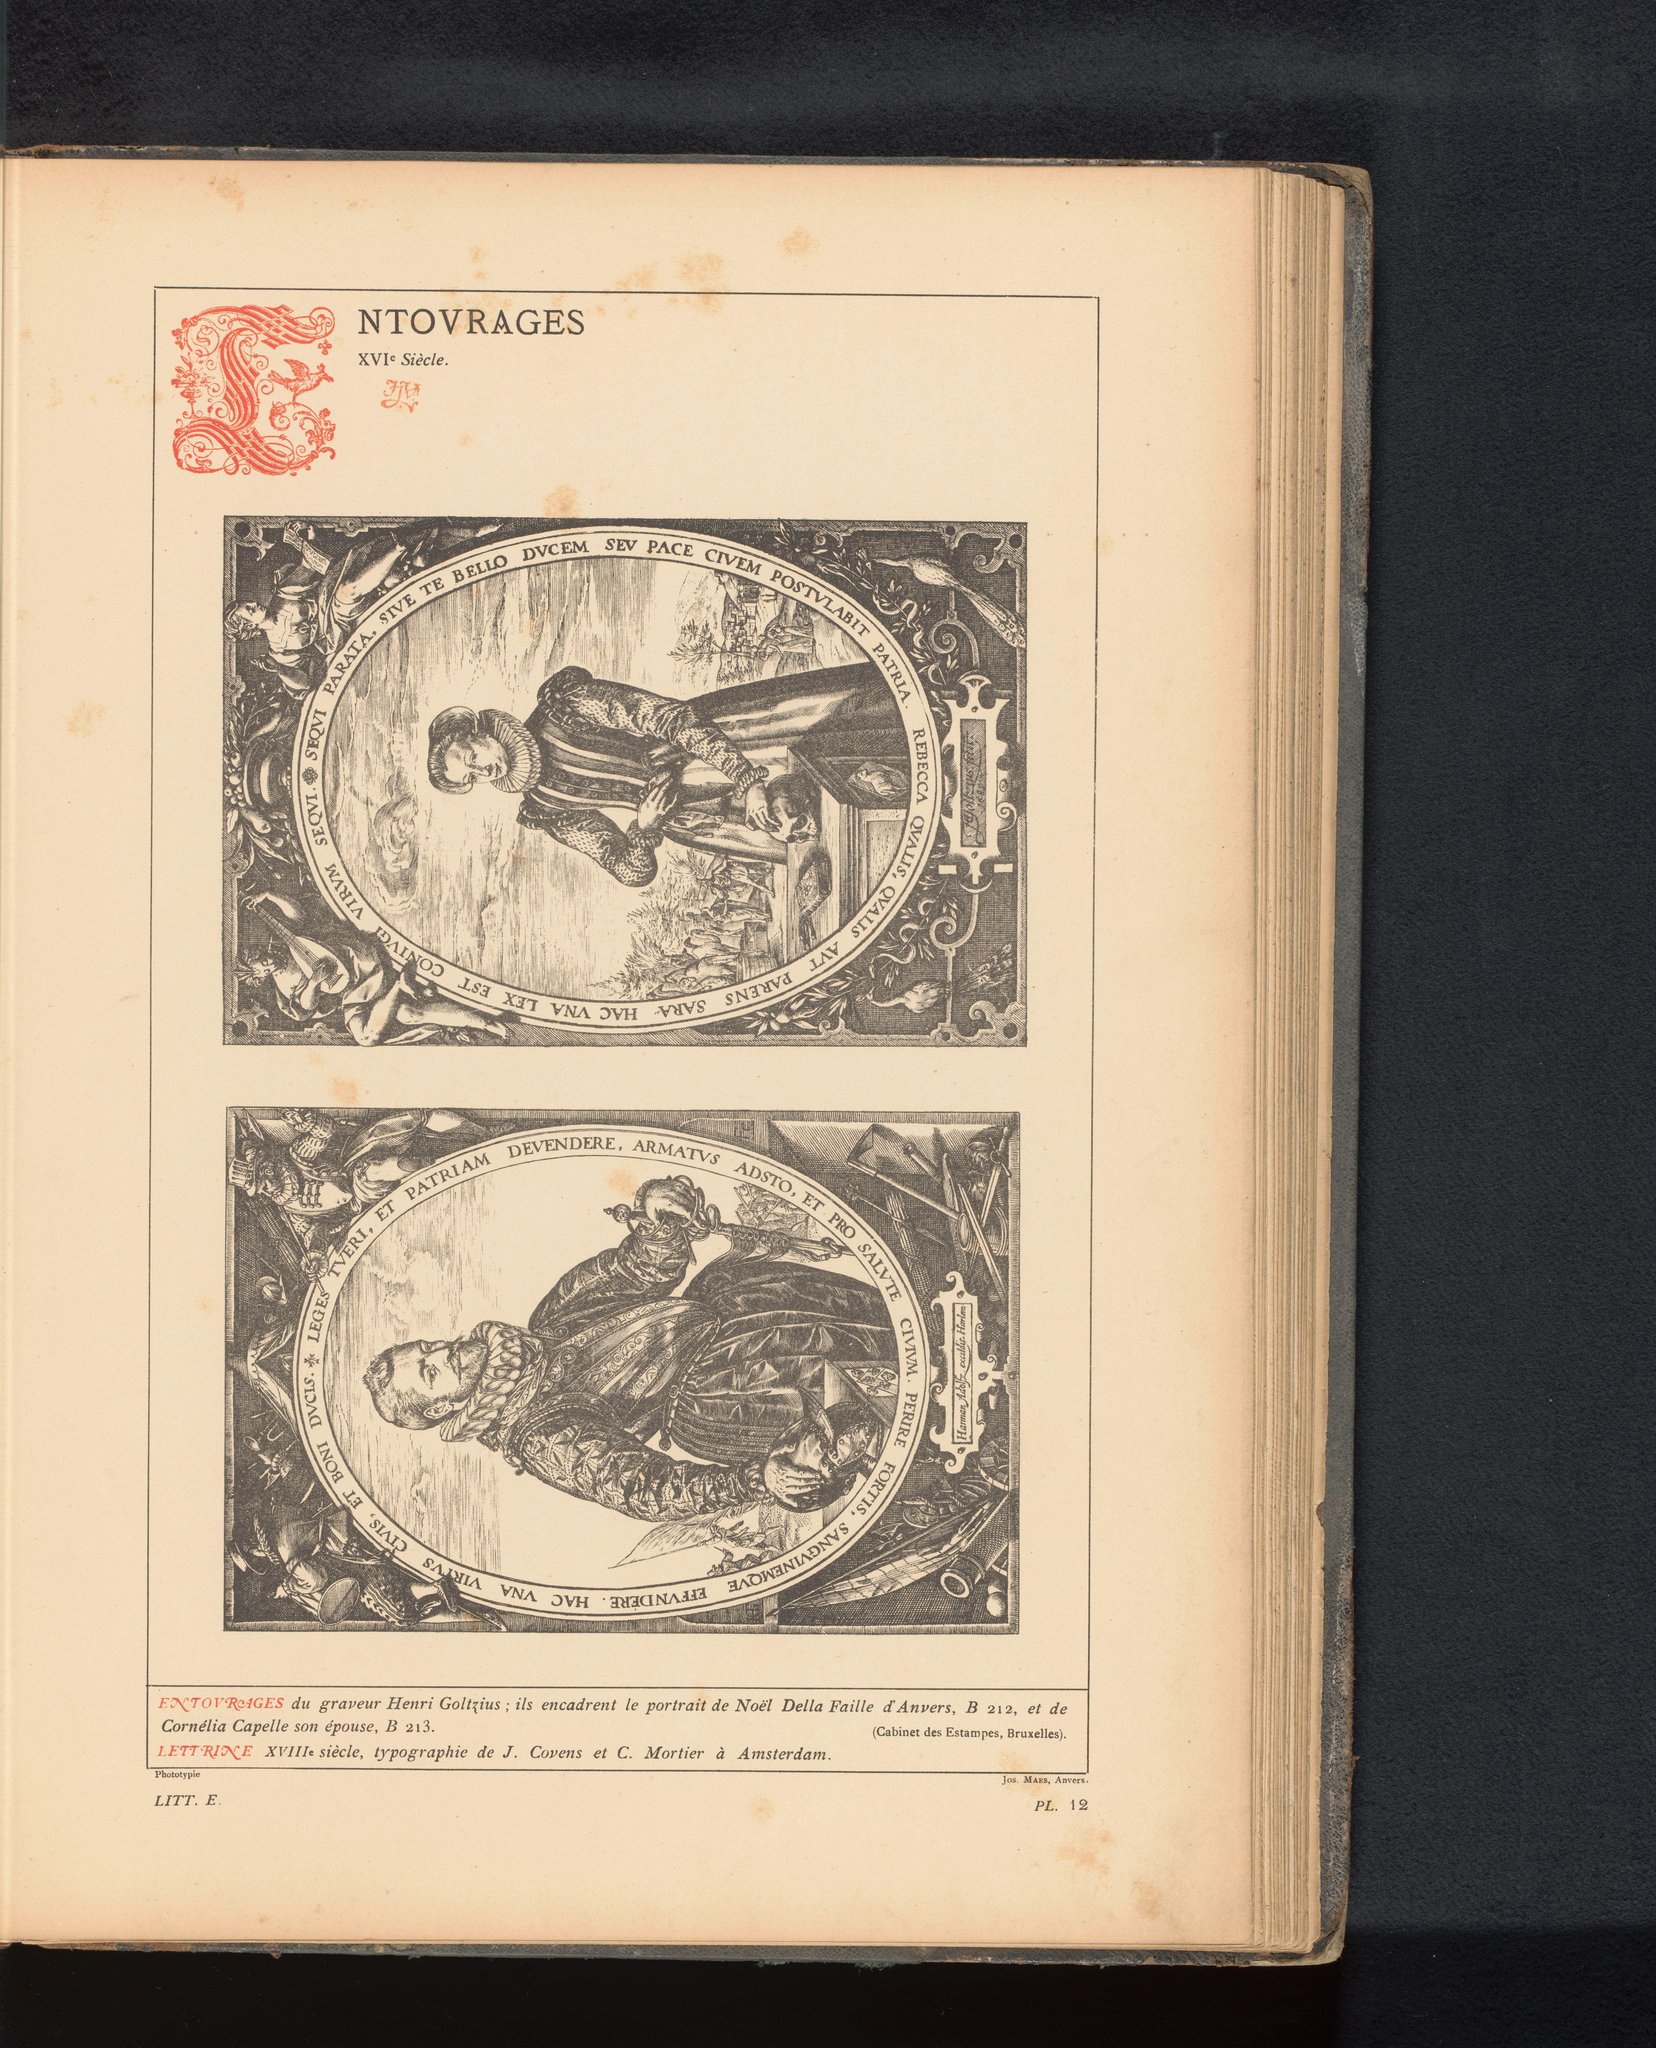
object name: page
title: Reproductie van een prent van een portret van Jan de la Faille omringd door grotesken en een prent van een portret van Cornelia van der Capelle omringd door grotesken, door Hendrick Goltzius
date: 1875-1880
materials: paper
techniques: photolithography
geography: amsterdam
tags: antwerp, ornament ~ grotesque, historical persons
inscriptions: inscription: ‘ENTOURAGES du graveur (...)’, inscription: ‘LITT. E. - PL. 12’, monogram: ‘JJvY’